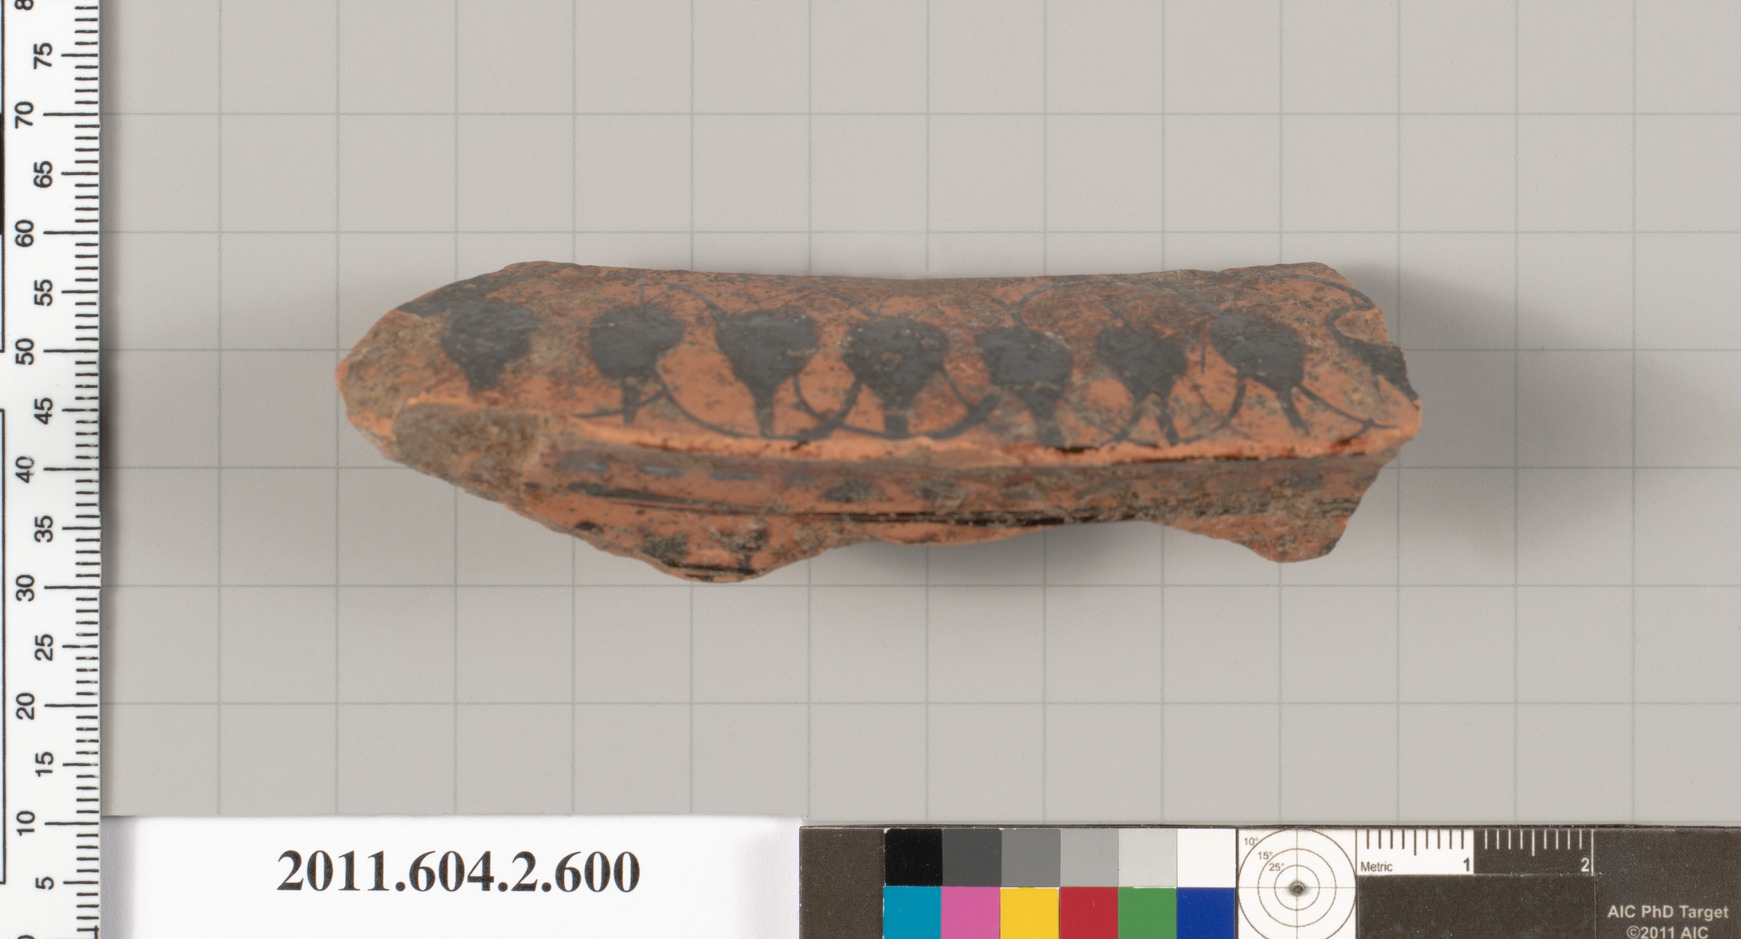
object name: column krater fragment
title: Terracotta fragment of a column-krater (bowl for mixing wine and water)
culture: greek, attic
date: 460-440 BCE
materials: terracotta